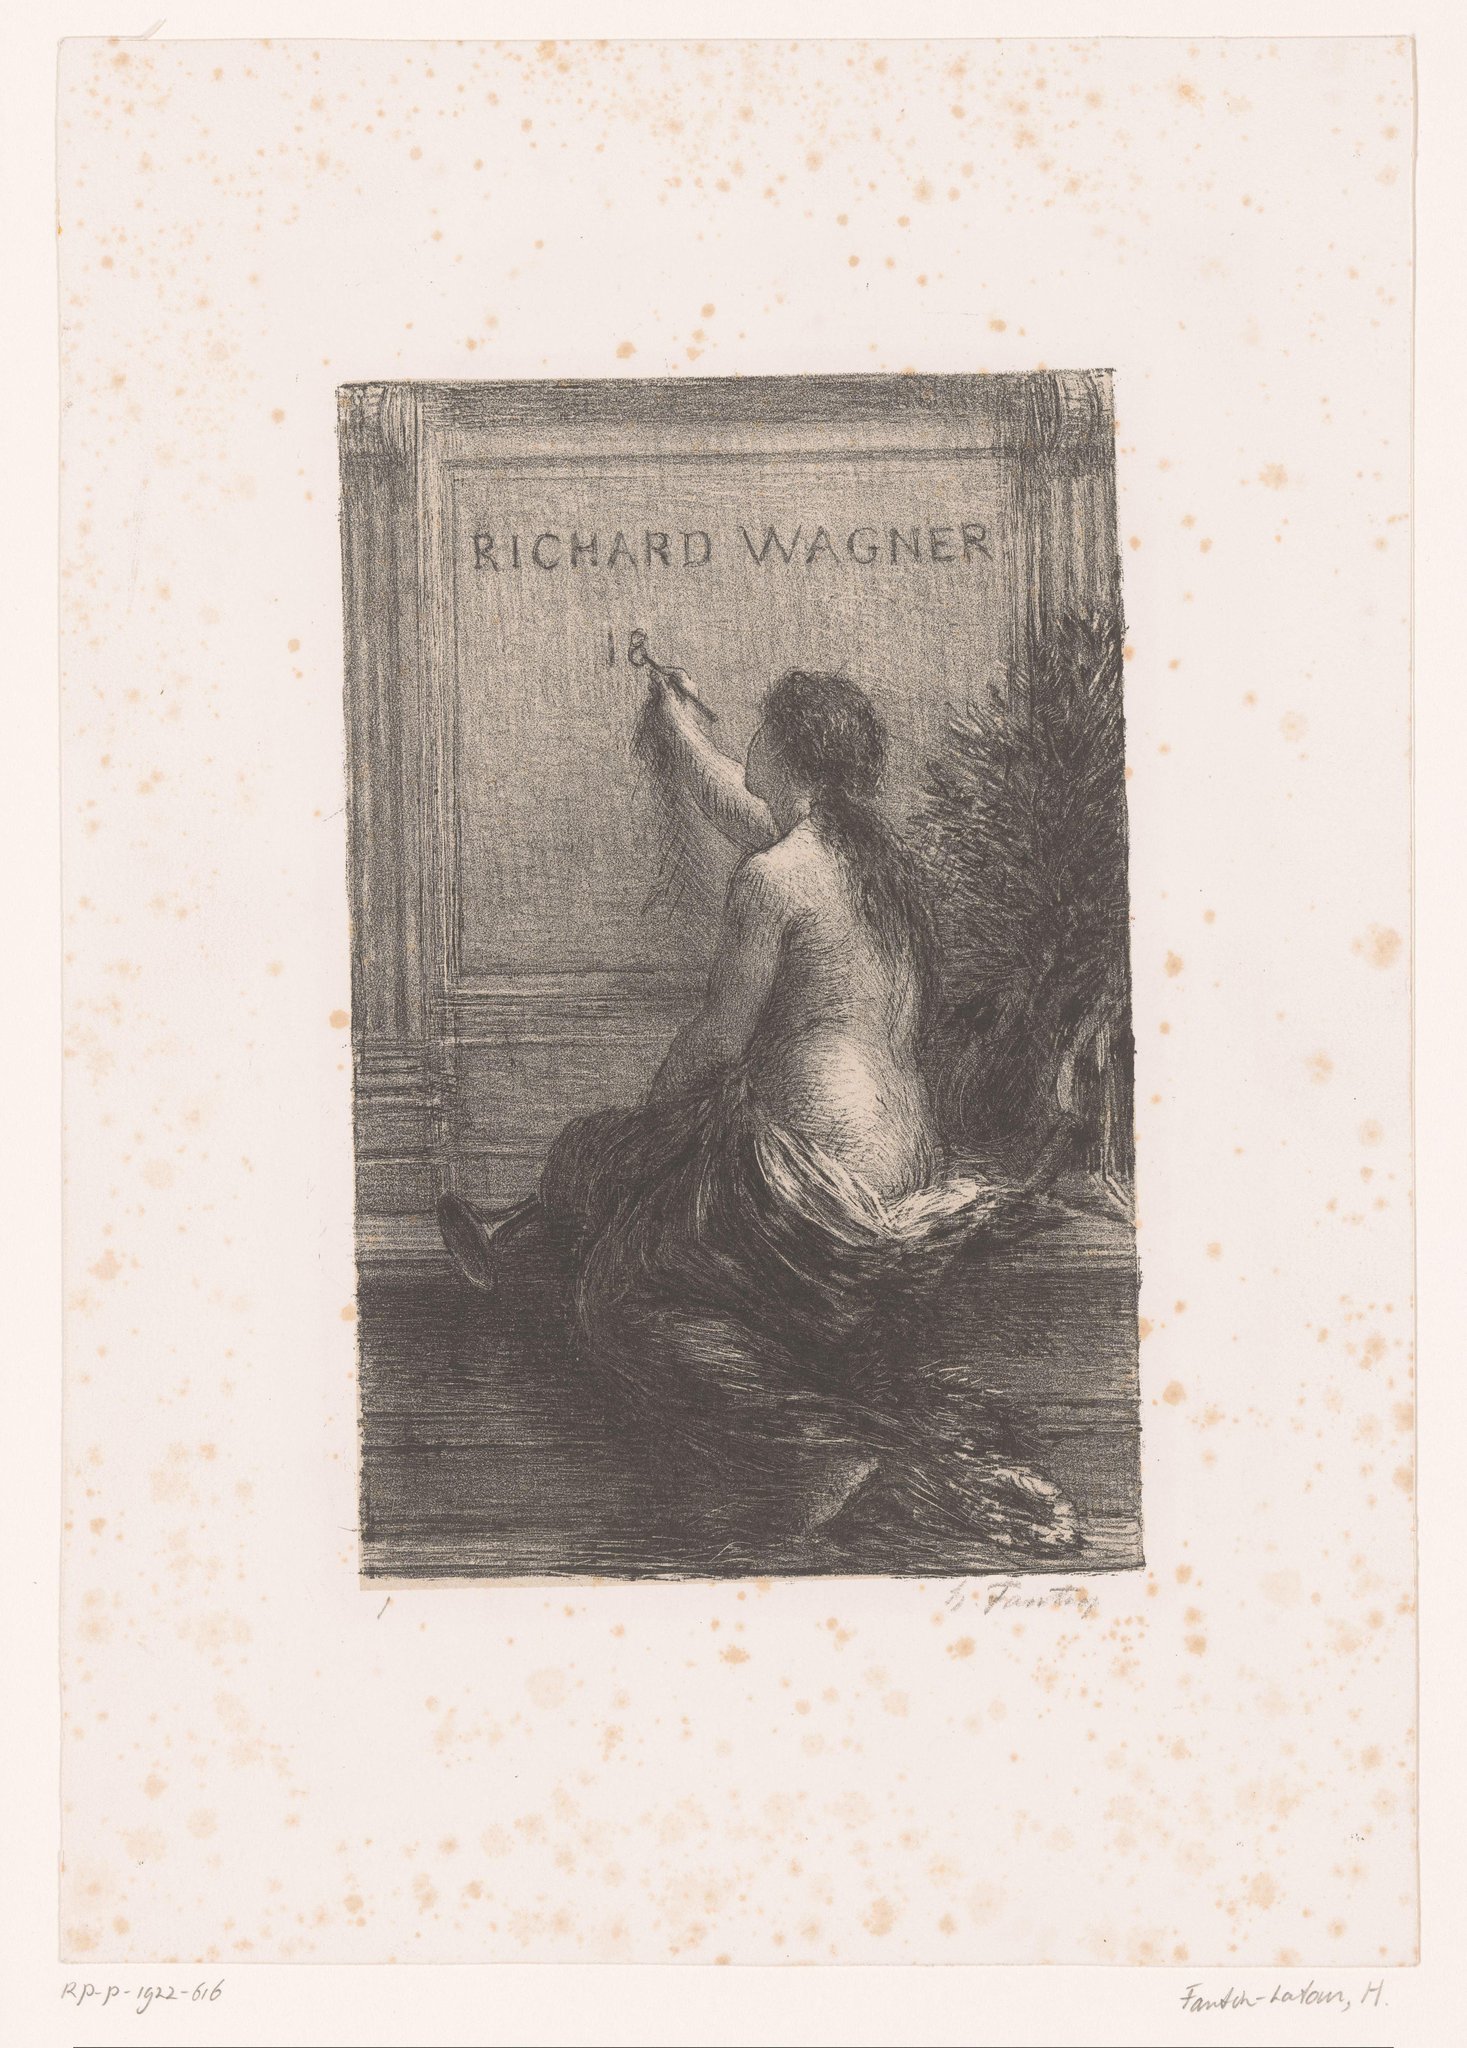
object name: print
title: Titelprent voor: Richard Wagner, sa vie et ses œuvres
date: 1886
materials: paper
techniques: lithography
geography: paris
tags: 'musica', symbolic representations, allegories and emblems ~ music; 'musica'(ripa), monumental artist, monument, statue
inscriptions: collector's mark: Lugt 2228a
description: Prent gebruikt voor: A. Jullien, Richard Wagner: sa vie et ses œuvres, Parijs 1886.